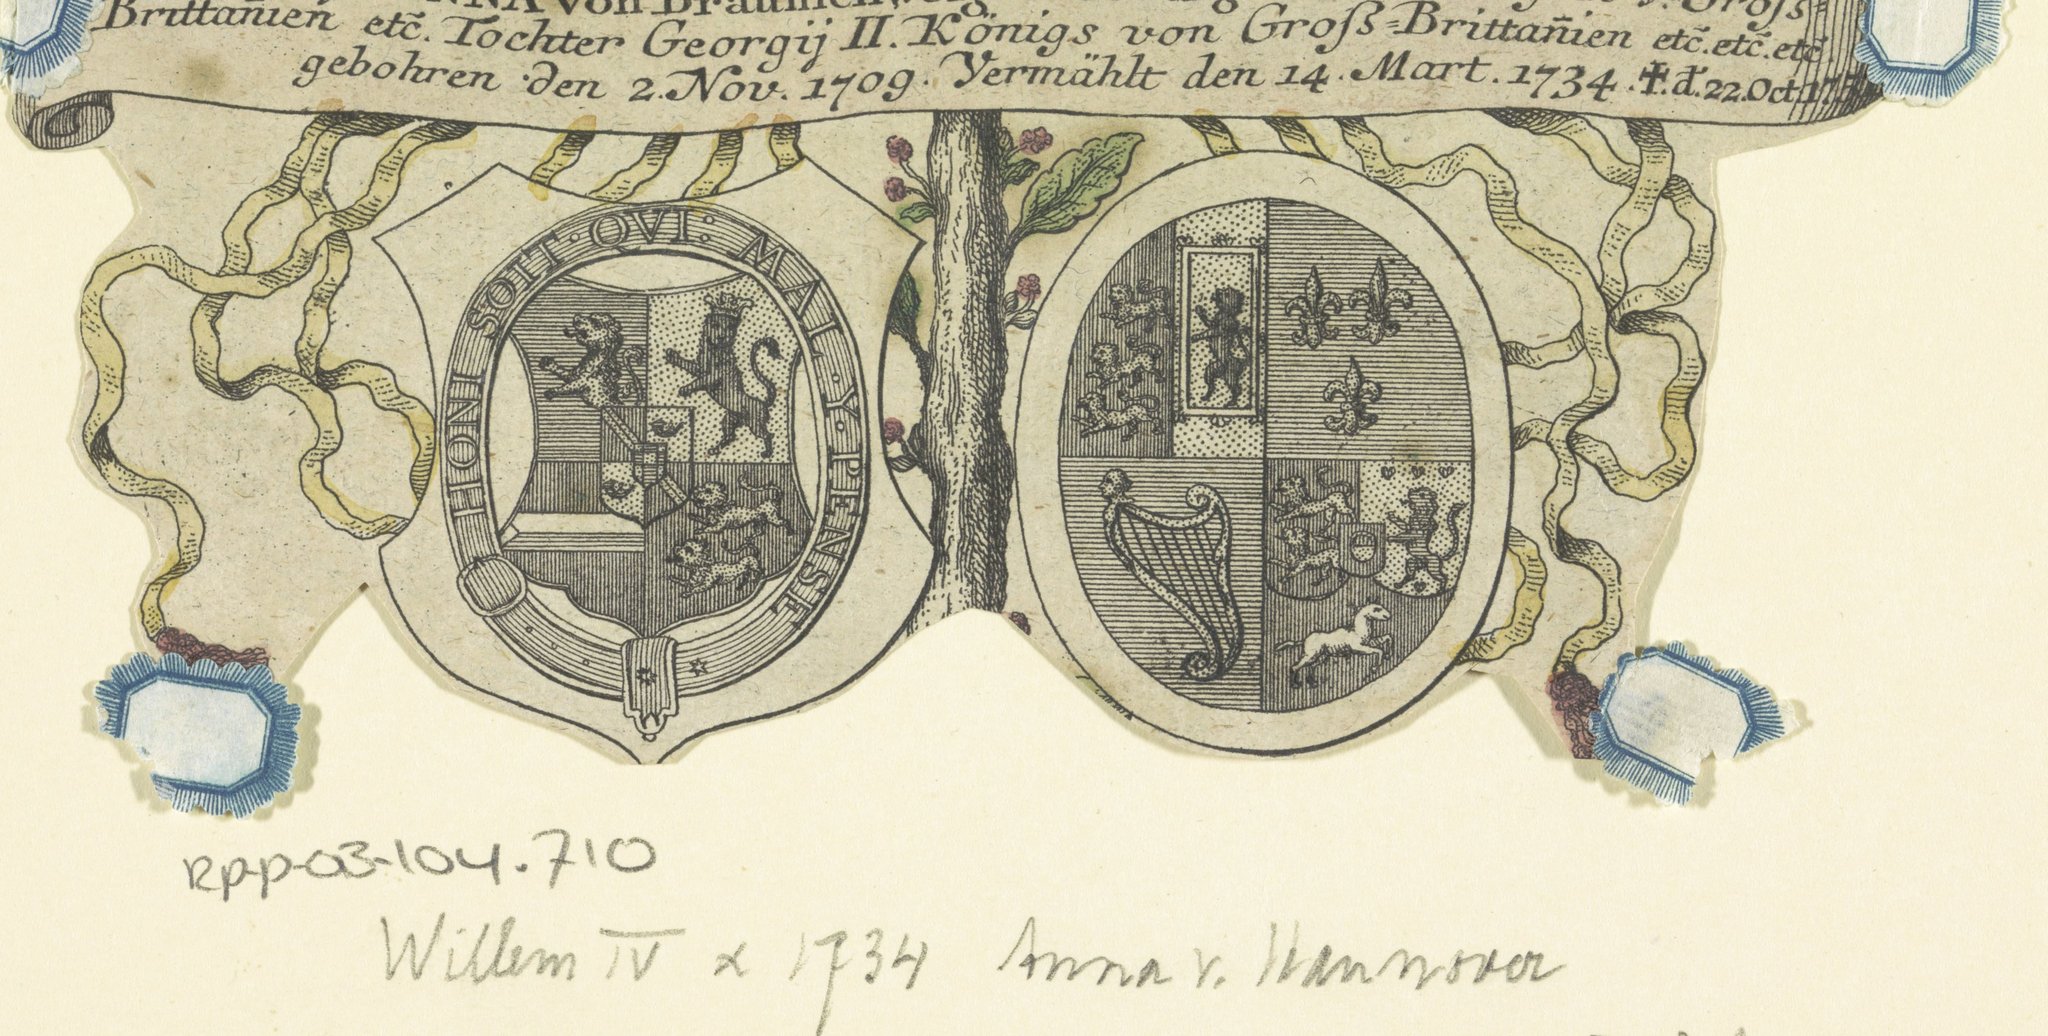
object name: print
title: Wapens van Willem IV, prins van Oranje-Nassau, en Anna van Hannover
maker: Anonymous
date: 1750-1849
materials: paper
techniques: engraving, hand coloring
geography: low countries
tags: willem iv (prins van oranje-nassau), the hague, anna van hannover, knighthood order (garter) - insignia of a knighthood order, e.g.: badge, chain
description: Wapens van Willem IV en Anna. In een cartouche zes regels Nederlandse tekst.